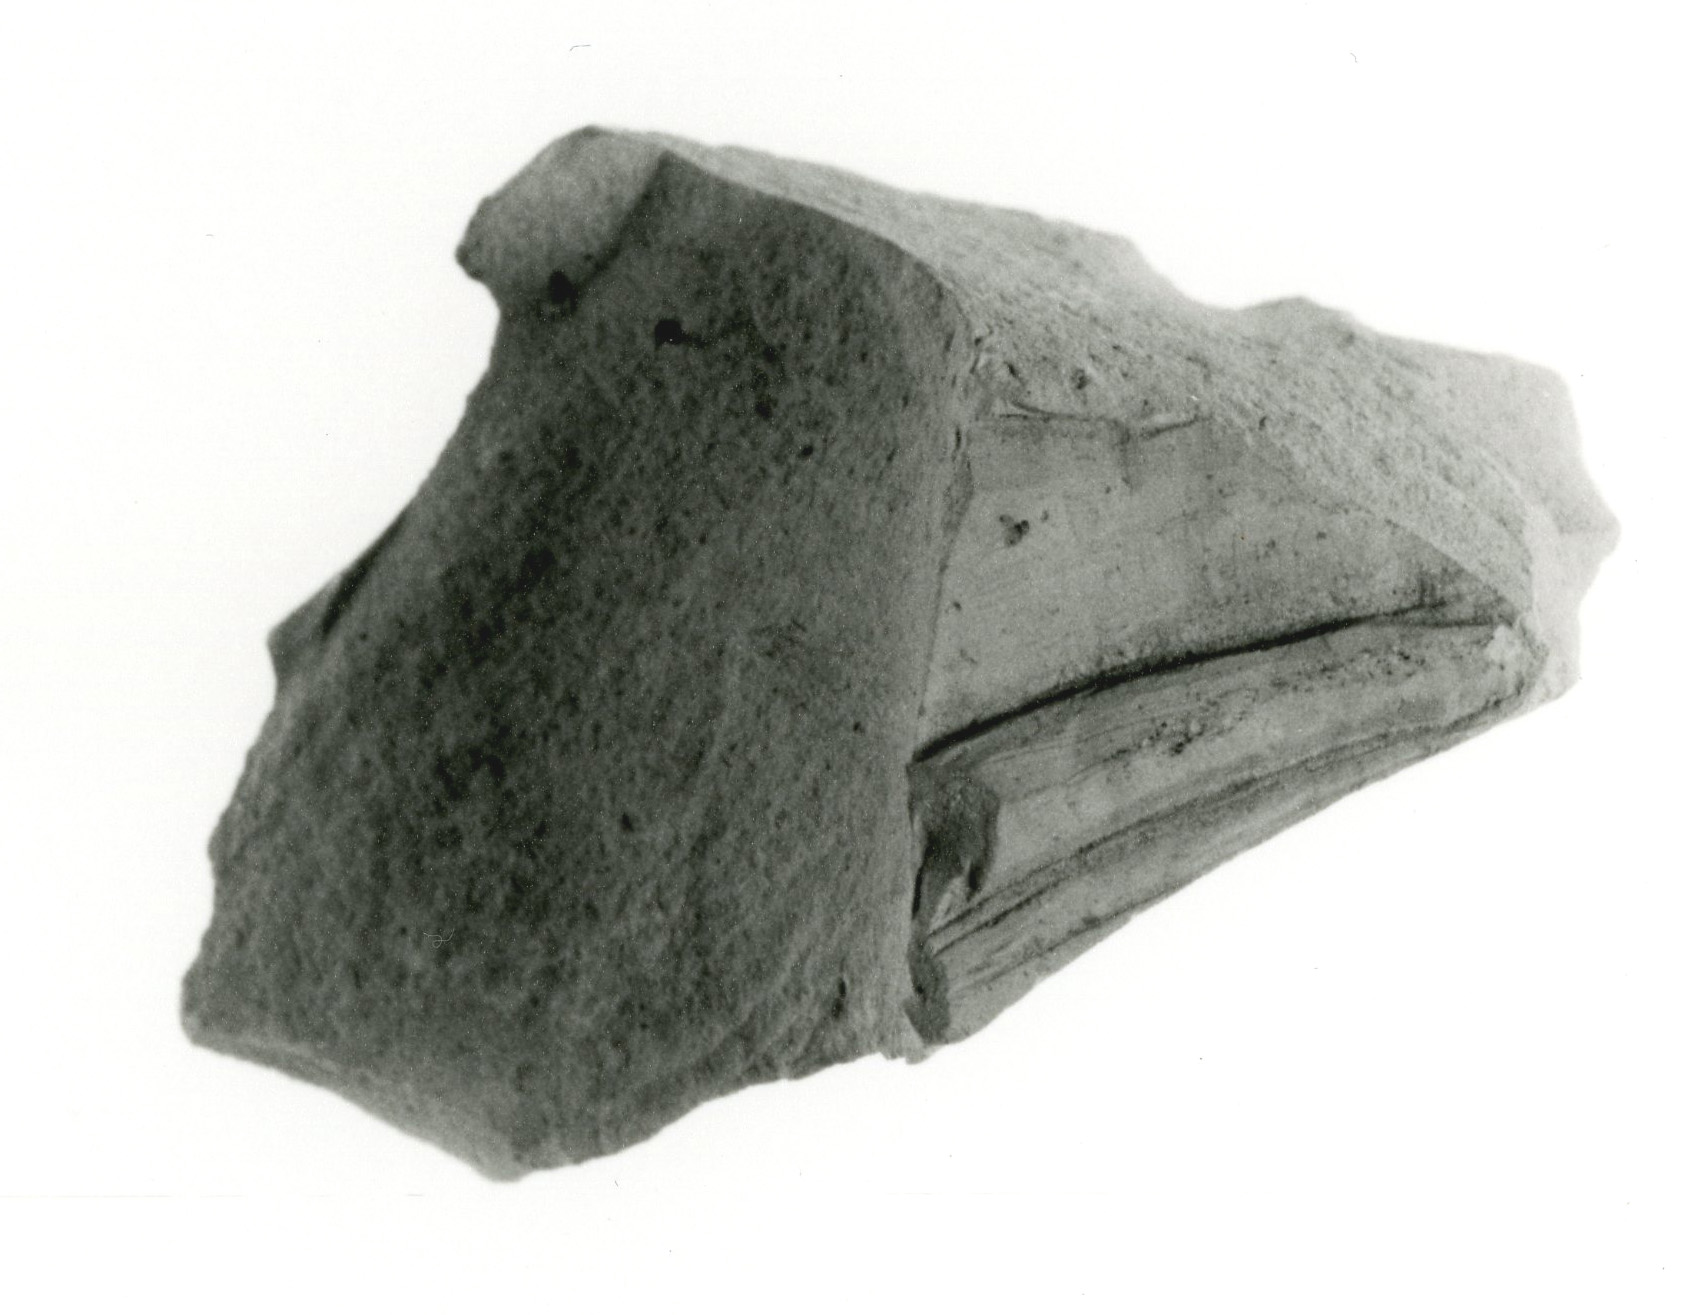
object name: relief, tomb of nespekashuty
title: Raised relief fragment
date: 664-610 BCE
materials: limestone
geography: egypt